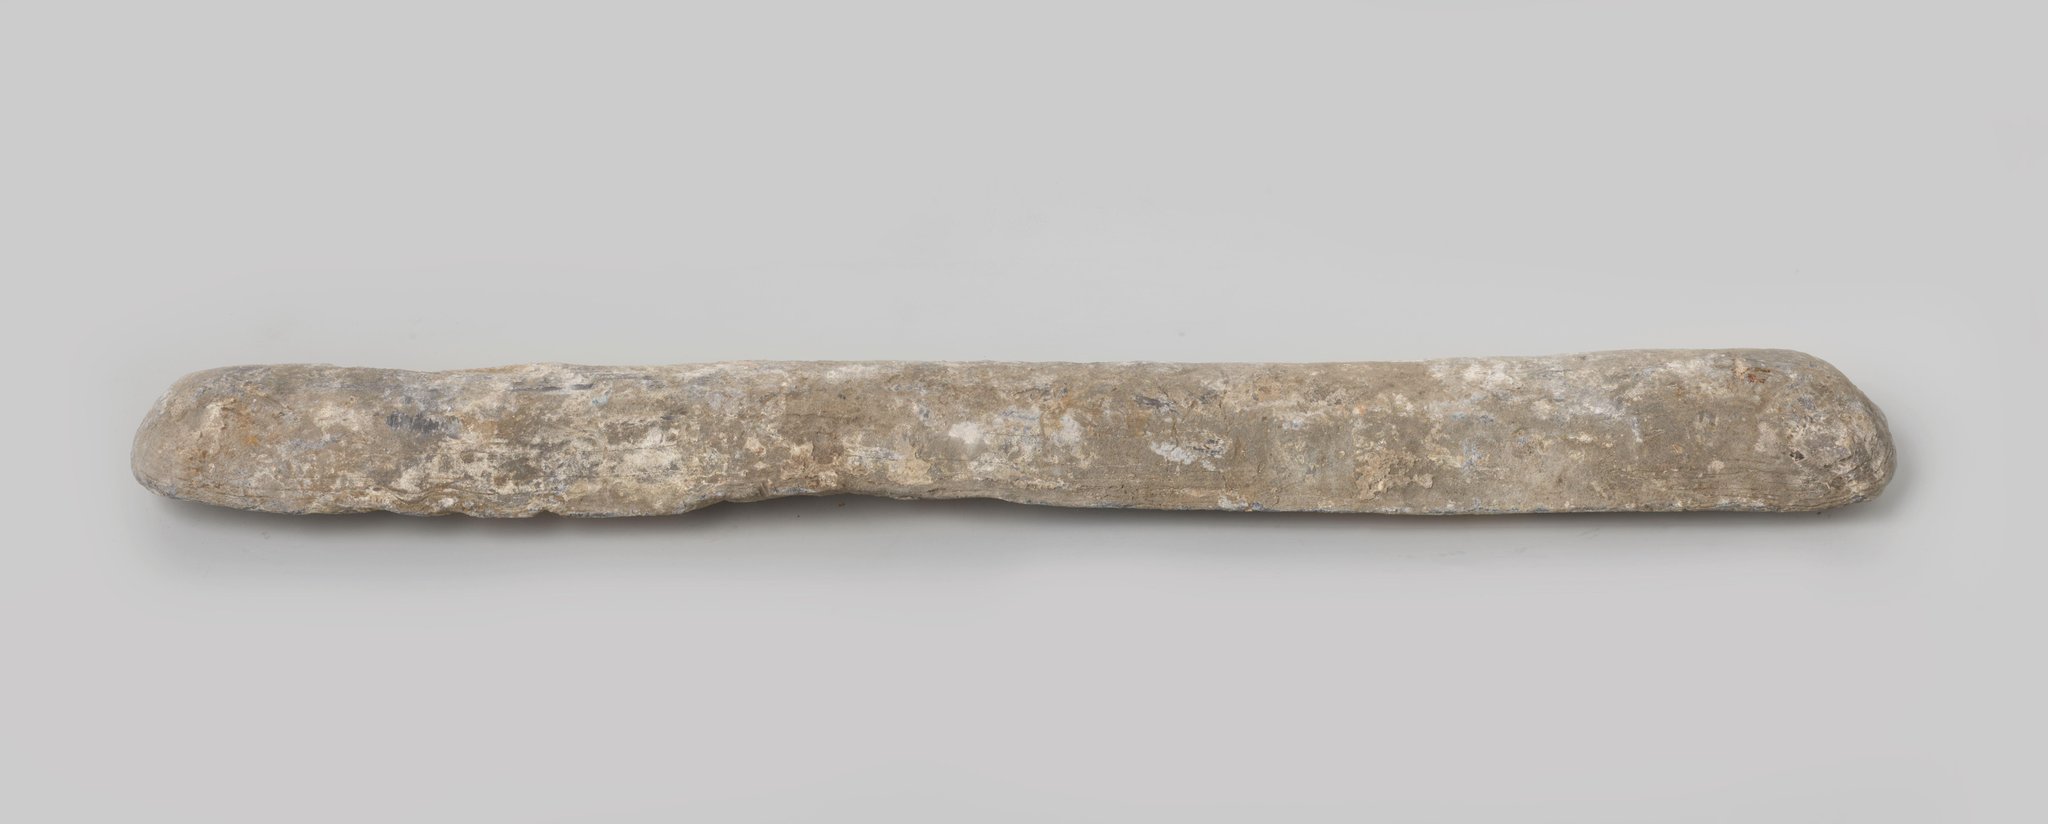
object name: ingot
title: Ballastlood uit het wrak van de Oost-Indiëvaarder Hollandia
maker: Anonymous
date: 1700-1743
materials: lead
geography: netherlands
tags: verenigde oostindische compagnie, hollandia (schip), annet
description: Ingot; (1) sim. NG 1979-268H, elongated (104.5l, 12.4w, 5.5h), corroded, marks visible [173, others illegible].